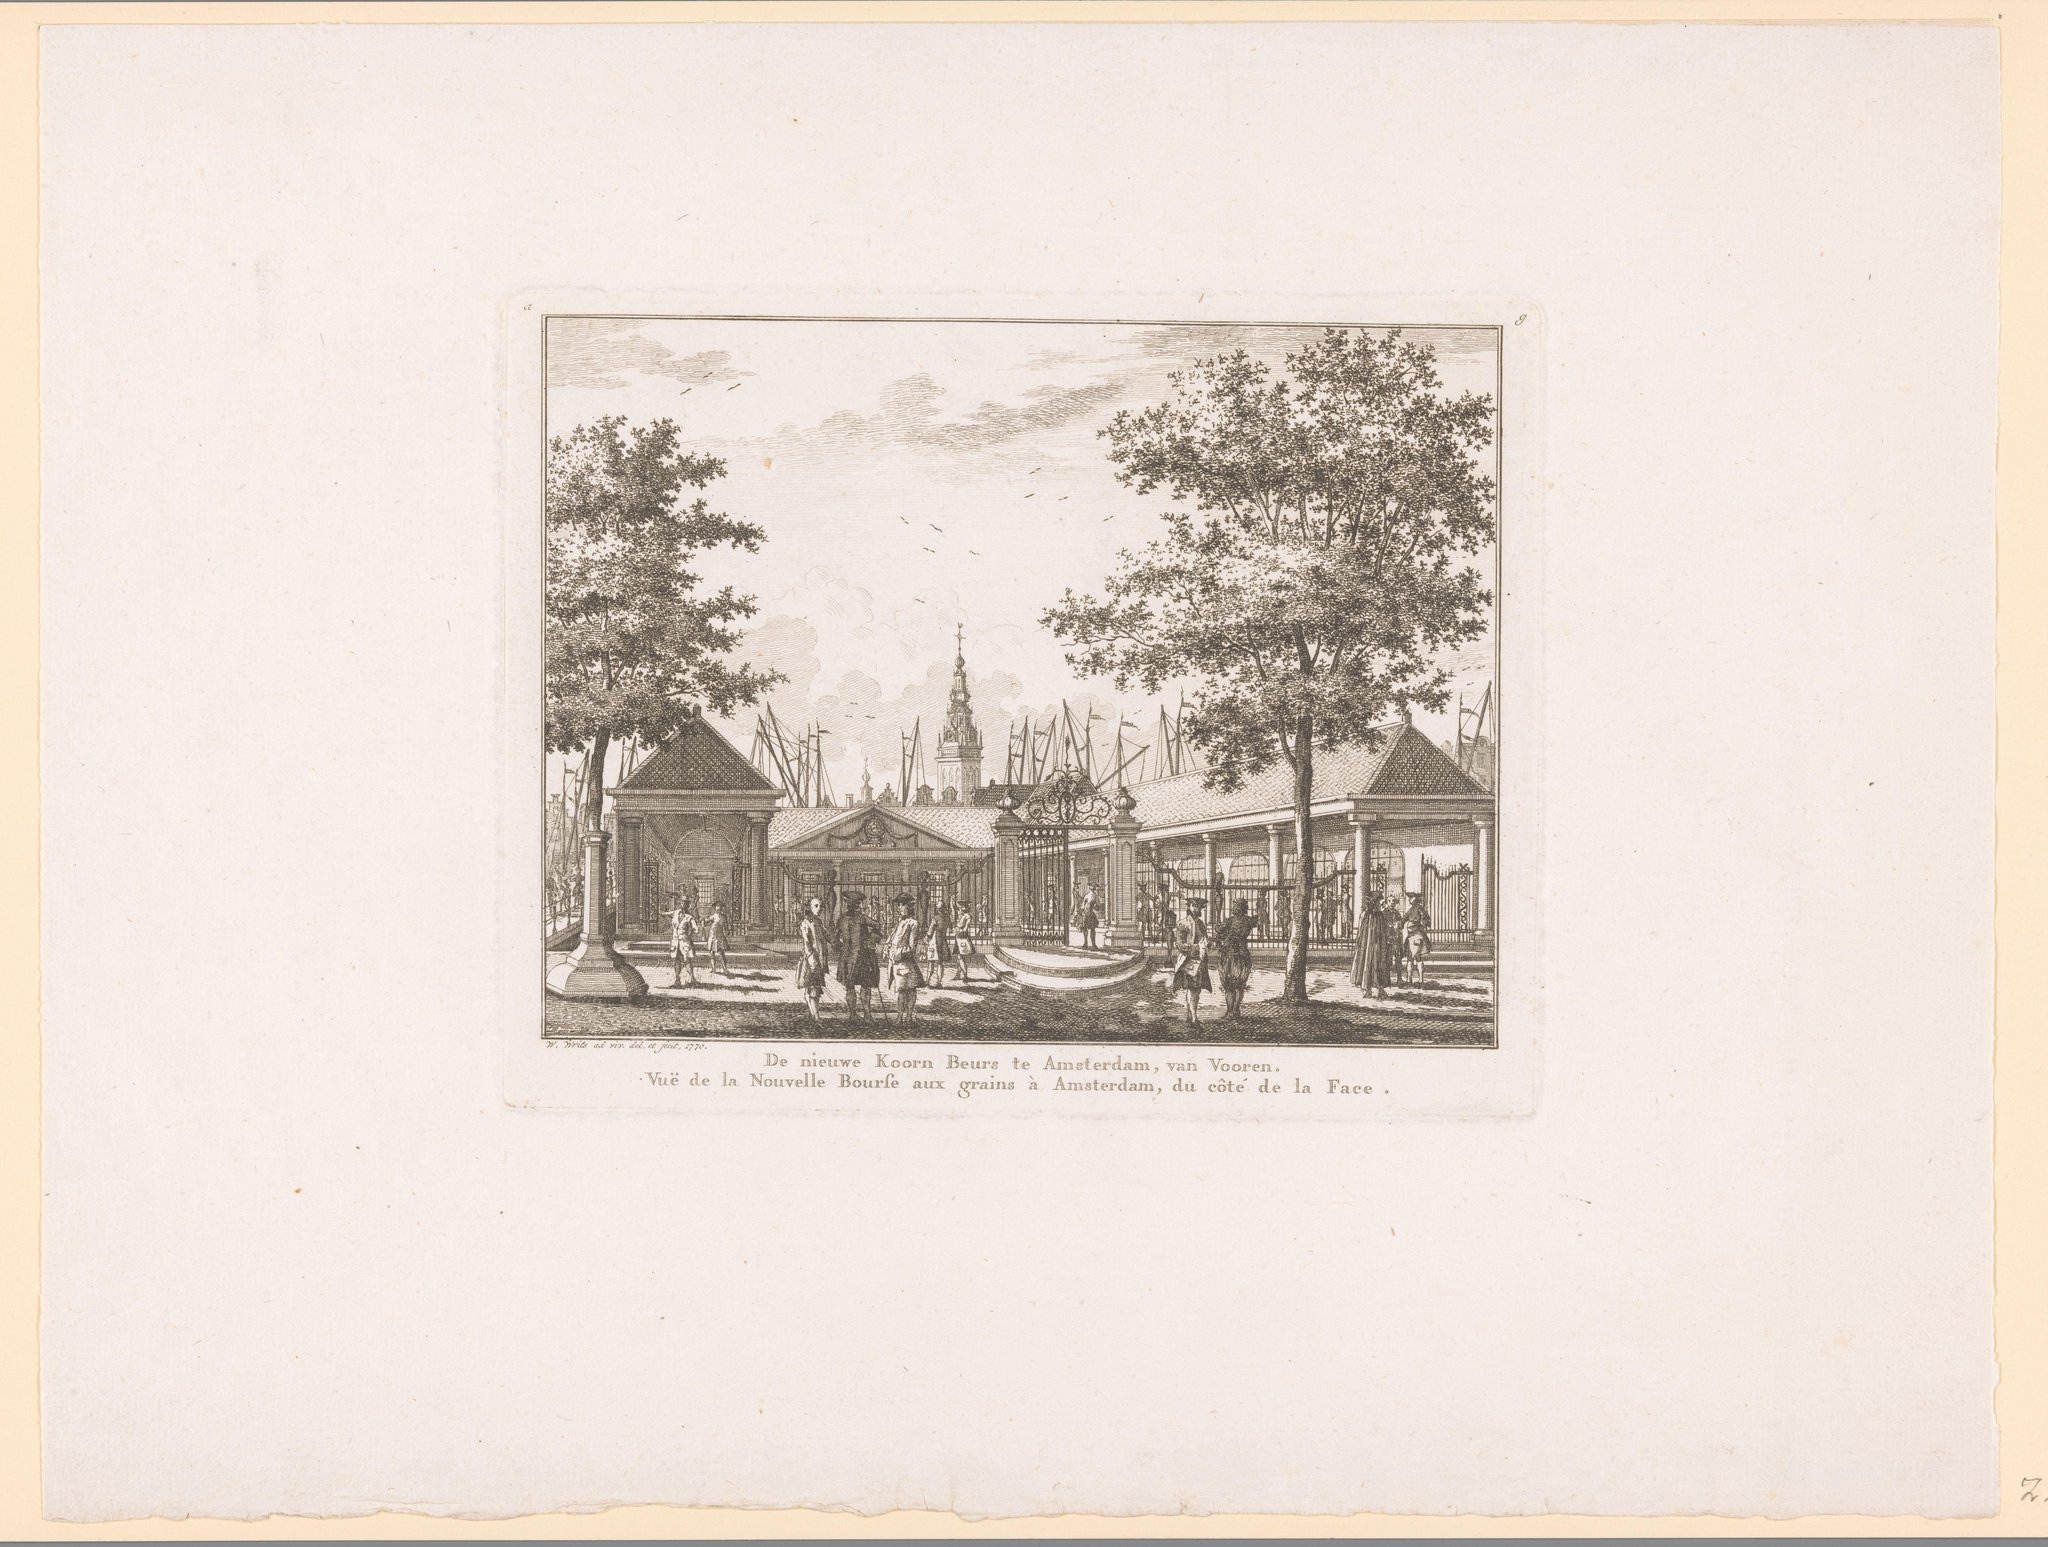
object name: book illustration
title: Gezicht op de Korenbeurs in Amsterdam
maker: willem writs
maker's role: draughtsman, print maker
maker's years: 1731-1786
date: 1770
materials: paper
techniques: etching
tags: sailing-ship, sailing-boat, market-hall, parts of church exterior and annexes: tower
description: De prent werd eerst in 1770 uitgegeven door onder anderen Reinier Ottens en Pieter Yver, als onderdeel van een serie stadsgezichten: de 'Atlas van de stad Amsterdam; of Afbeelding der voornaamste gezichten, gebouwen, oudheeden en historien van Amsterdam (...)'. Deze serie, begonnen in 1769, bevatte prenten met tekstuele toelichting die konden worden ingebonden in verschillende publicaties over Amsterdam. De prent werd ook nog gebruikt in: Atlas van de waereldberoemde koopstad Amsteldam (...). Amsterdam: Jan Barend Elwe, 1804. In die publicatie is een achteraanzicht van de Korenbeurs onder deze prent gedrukt. Latere staat, genummerd rechtsboven met pl. 1, gebruikt in publicatie uit 1824.